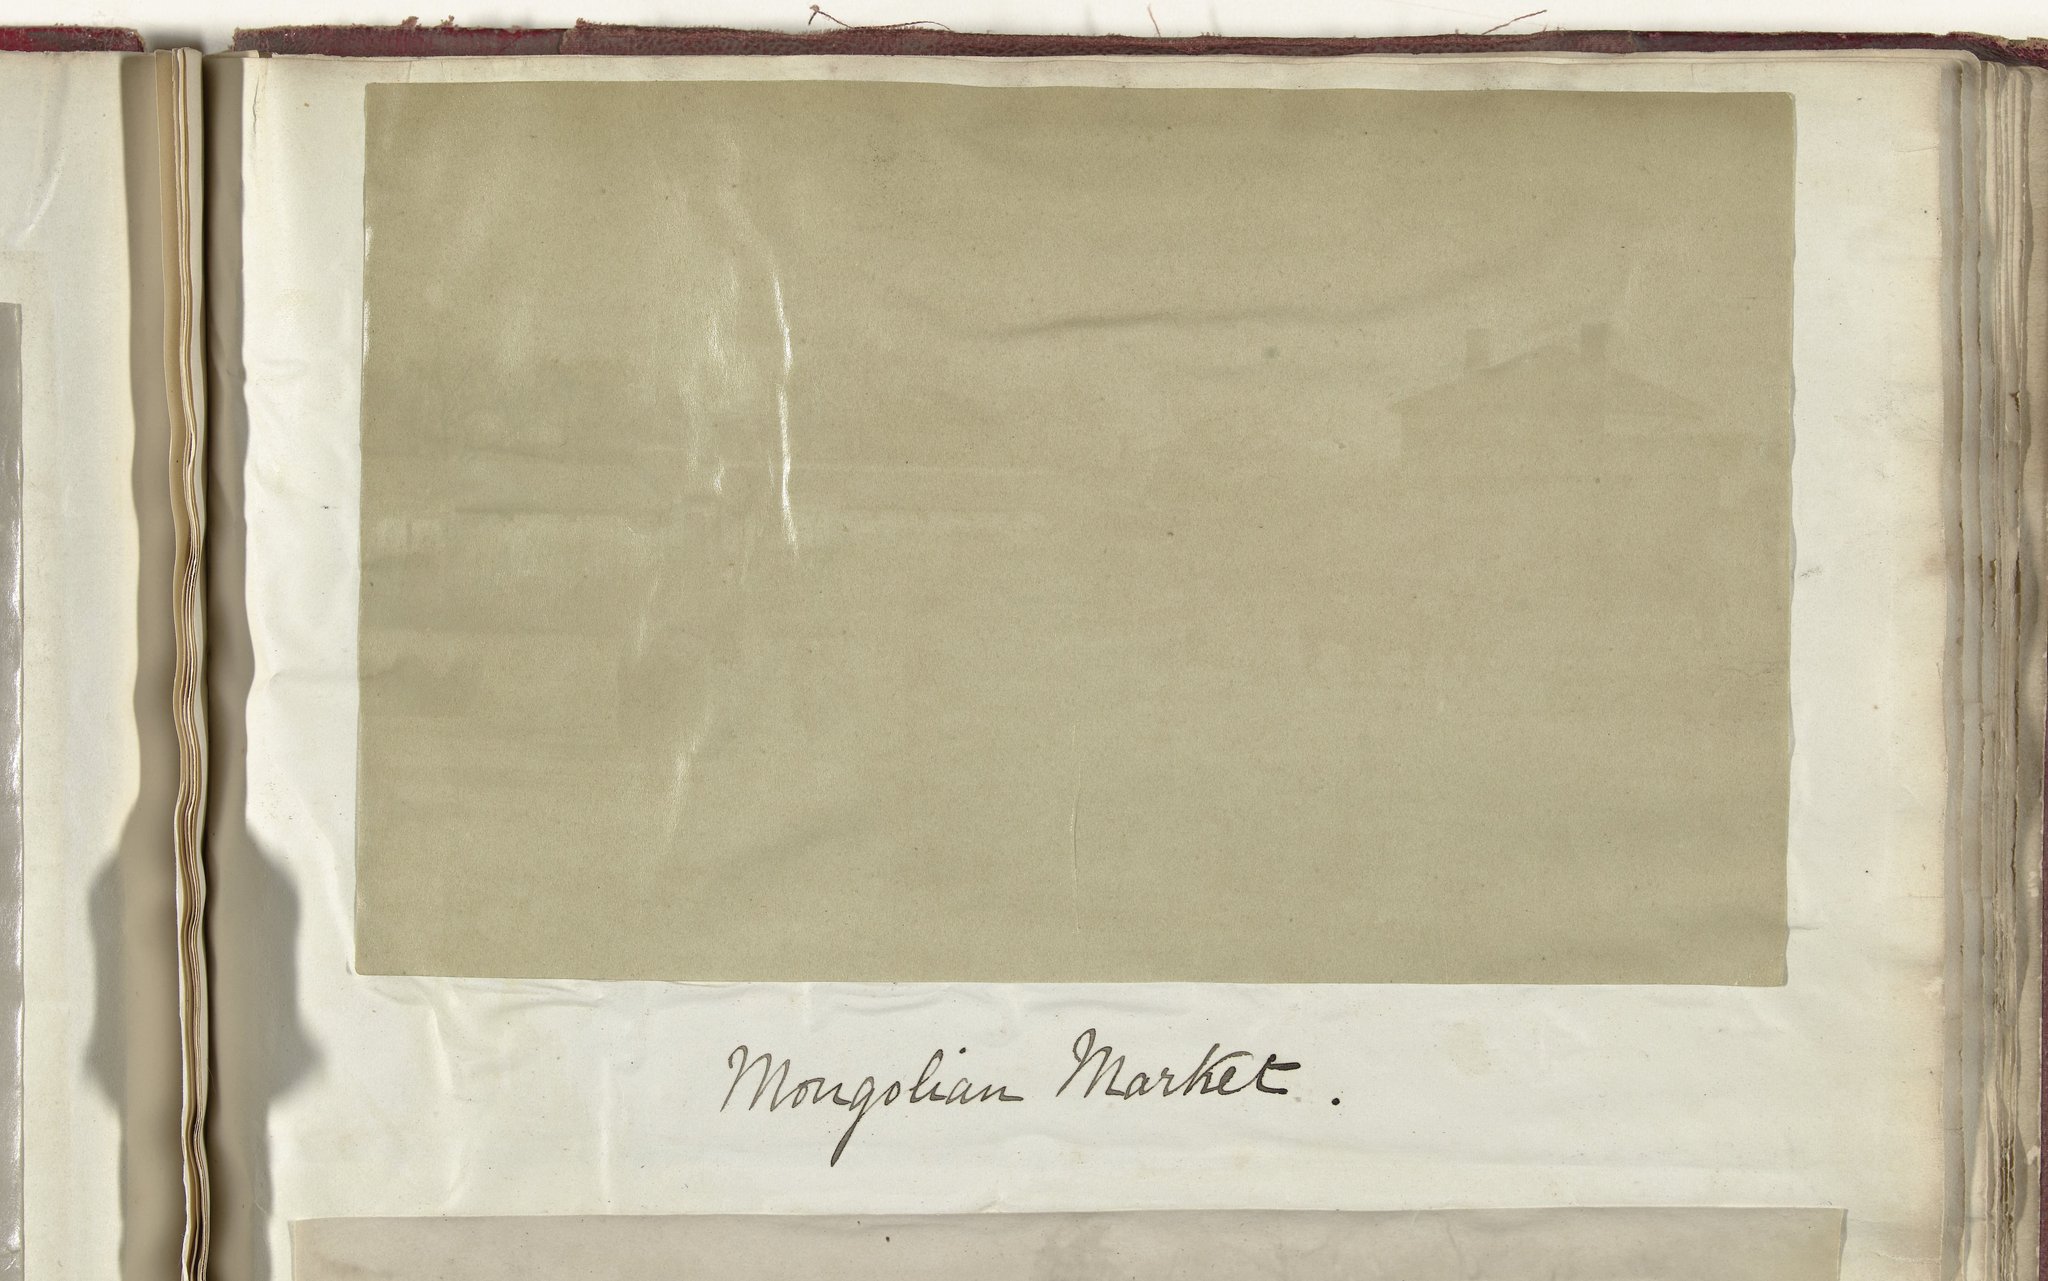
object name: album leaf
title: Gebouw in een straat, China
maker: Anonymous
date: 1879-1890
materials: paper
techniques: albumen print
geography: china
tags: urban housing, street, china